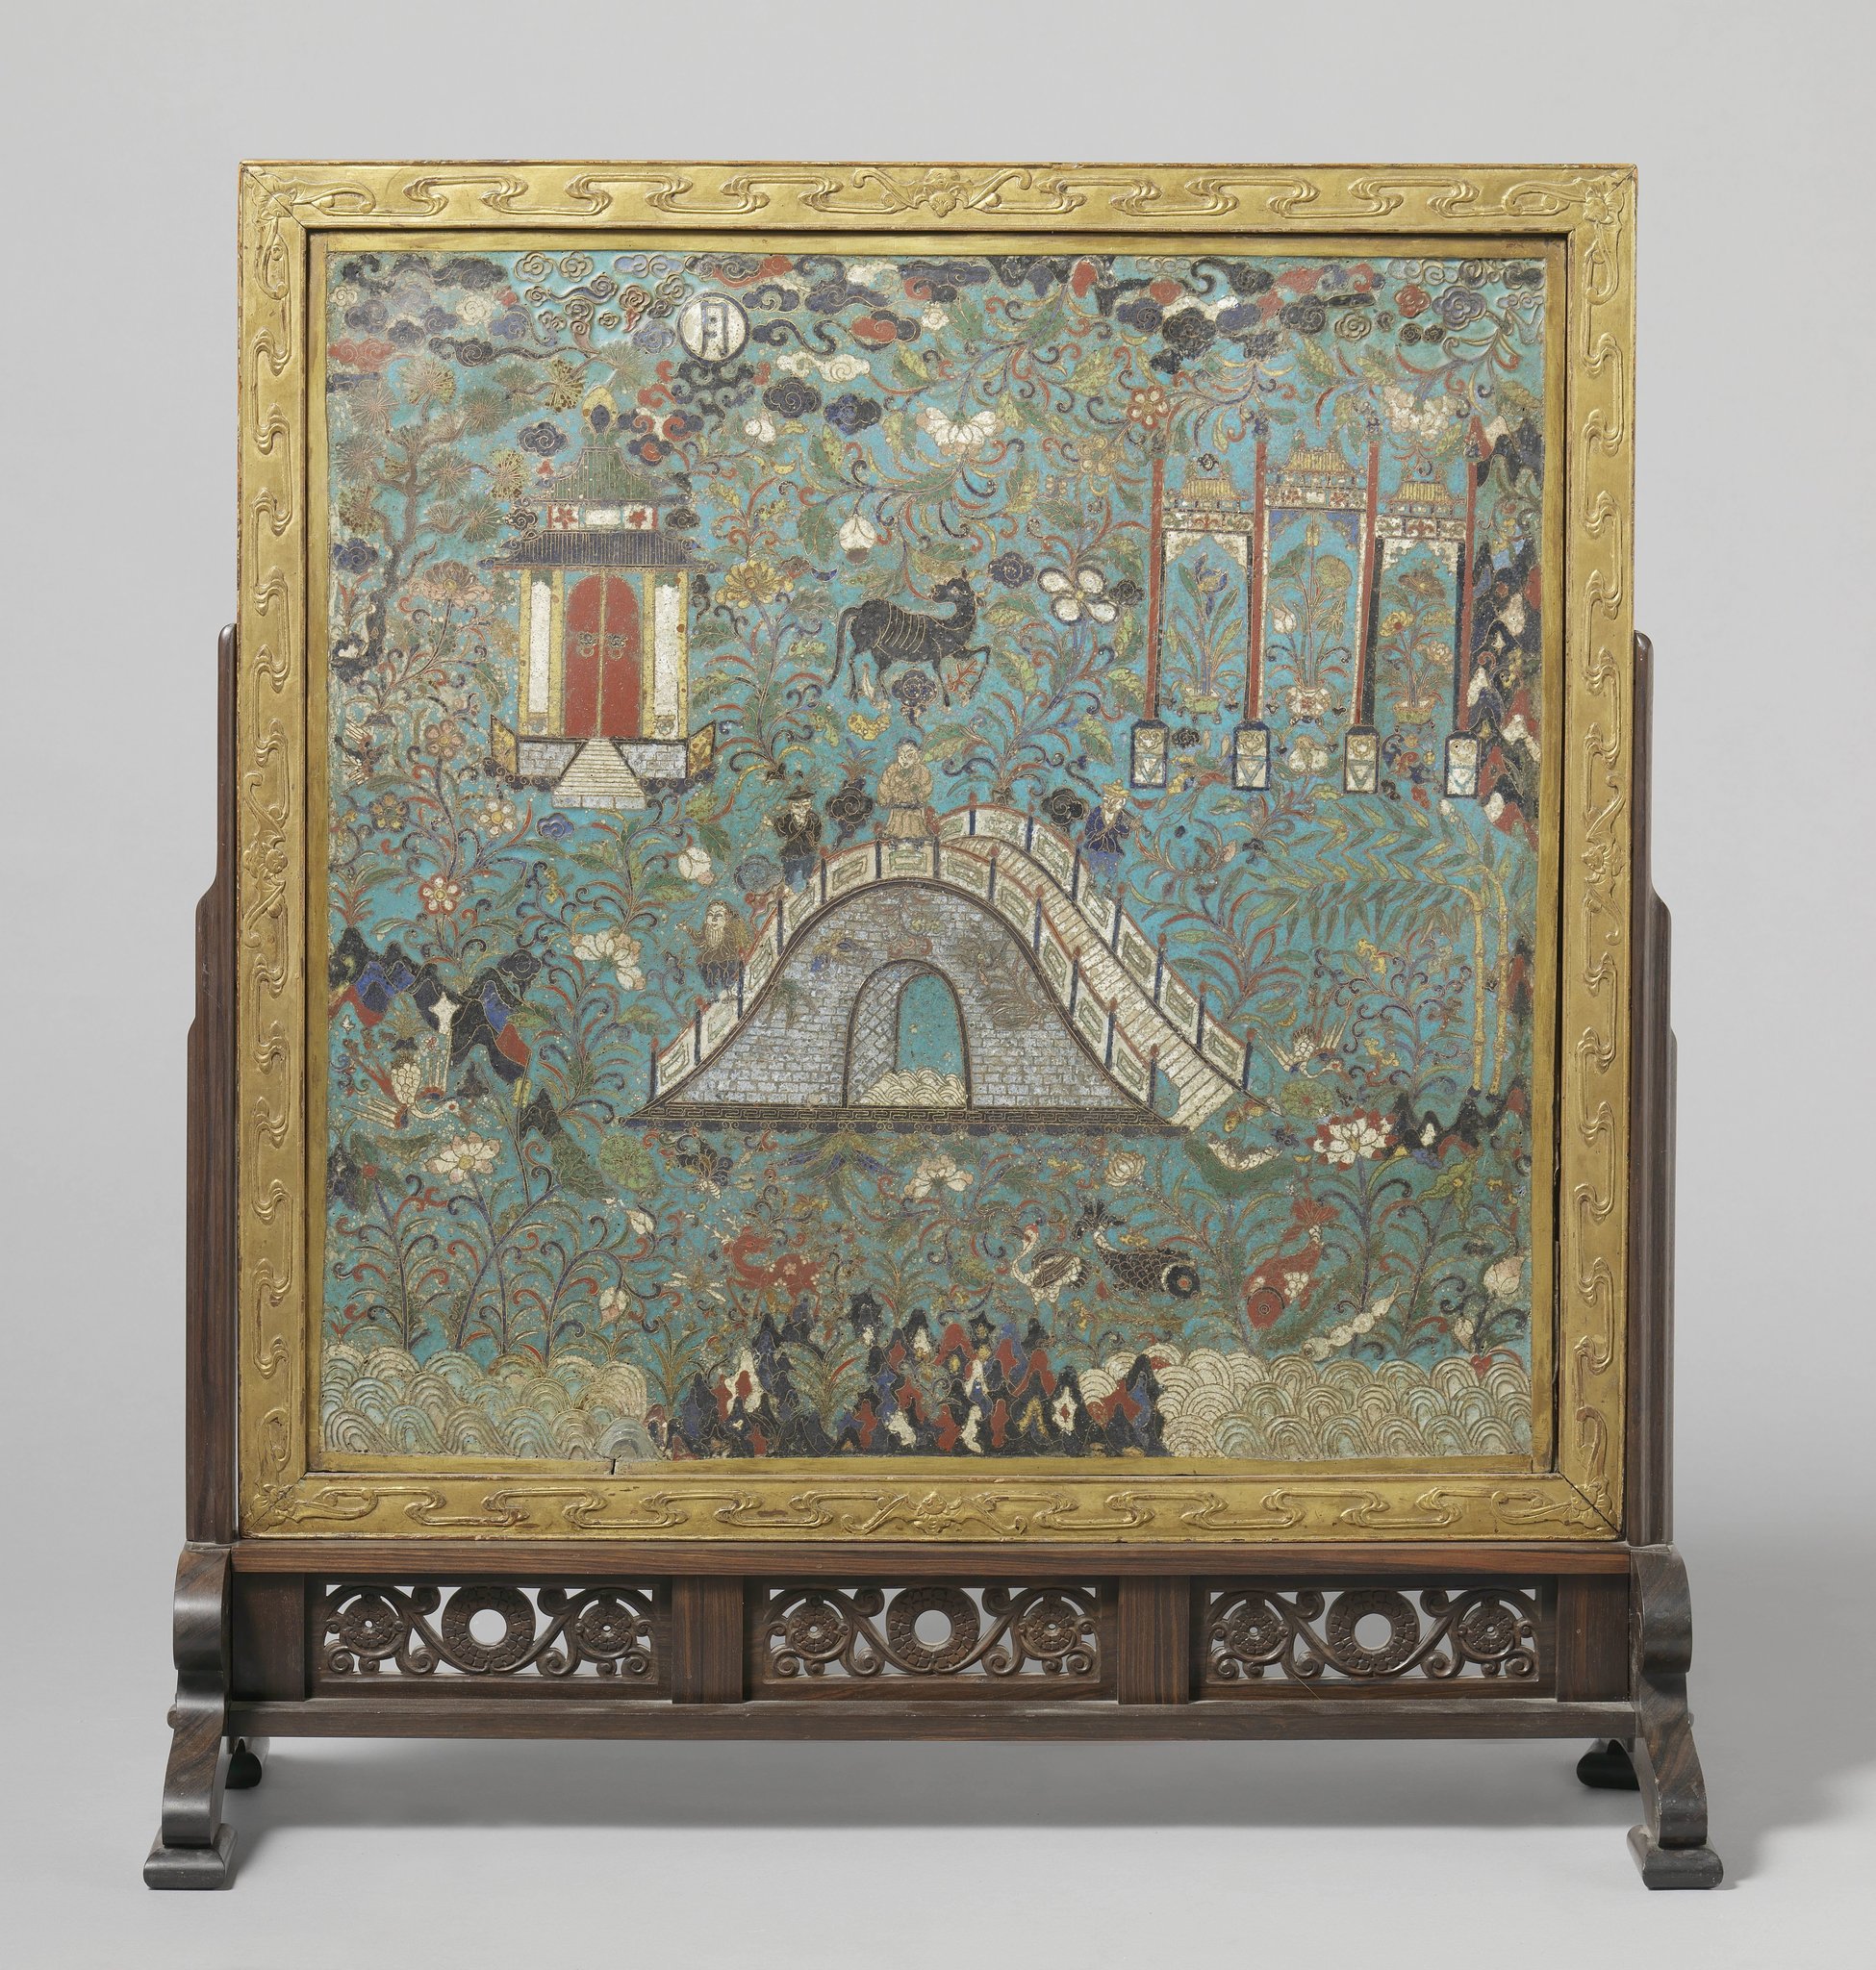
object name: houder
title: Houder waarin cloisonné plaque gemonteerd kan worden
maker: Anonymous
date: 1700-1800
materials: wood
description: Westerse houten voet, waardoor het vierkante paneel versierd met email cloisonné kan functioneren als haardscherm.